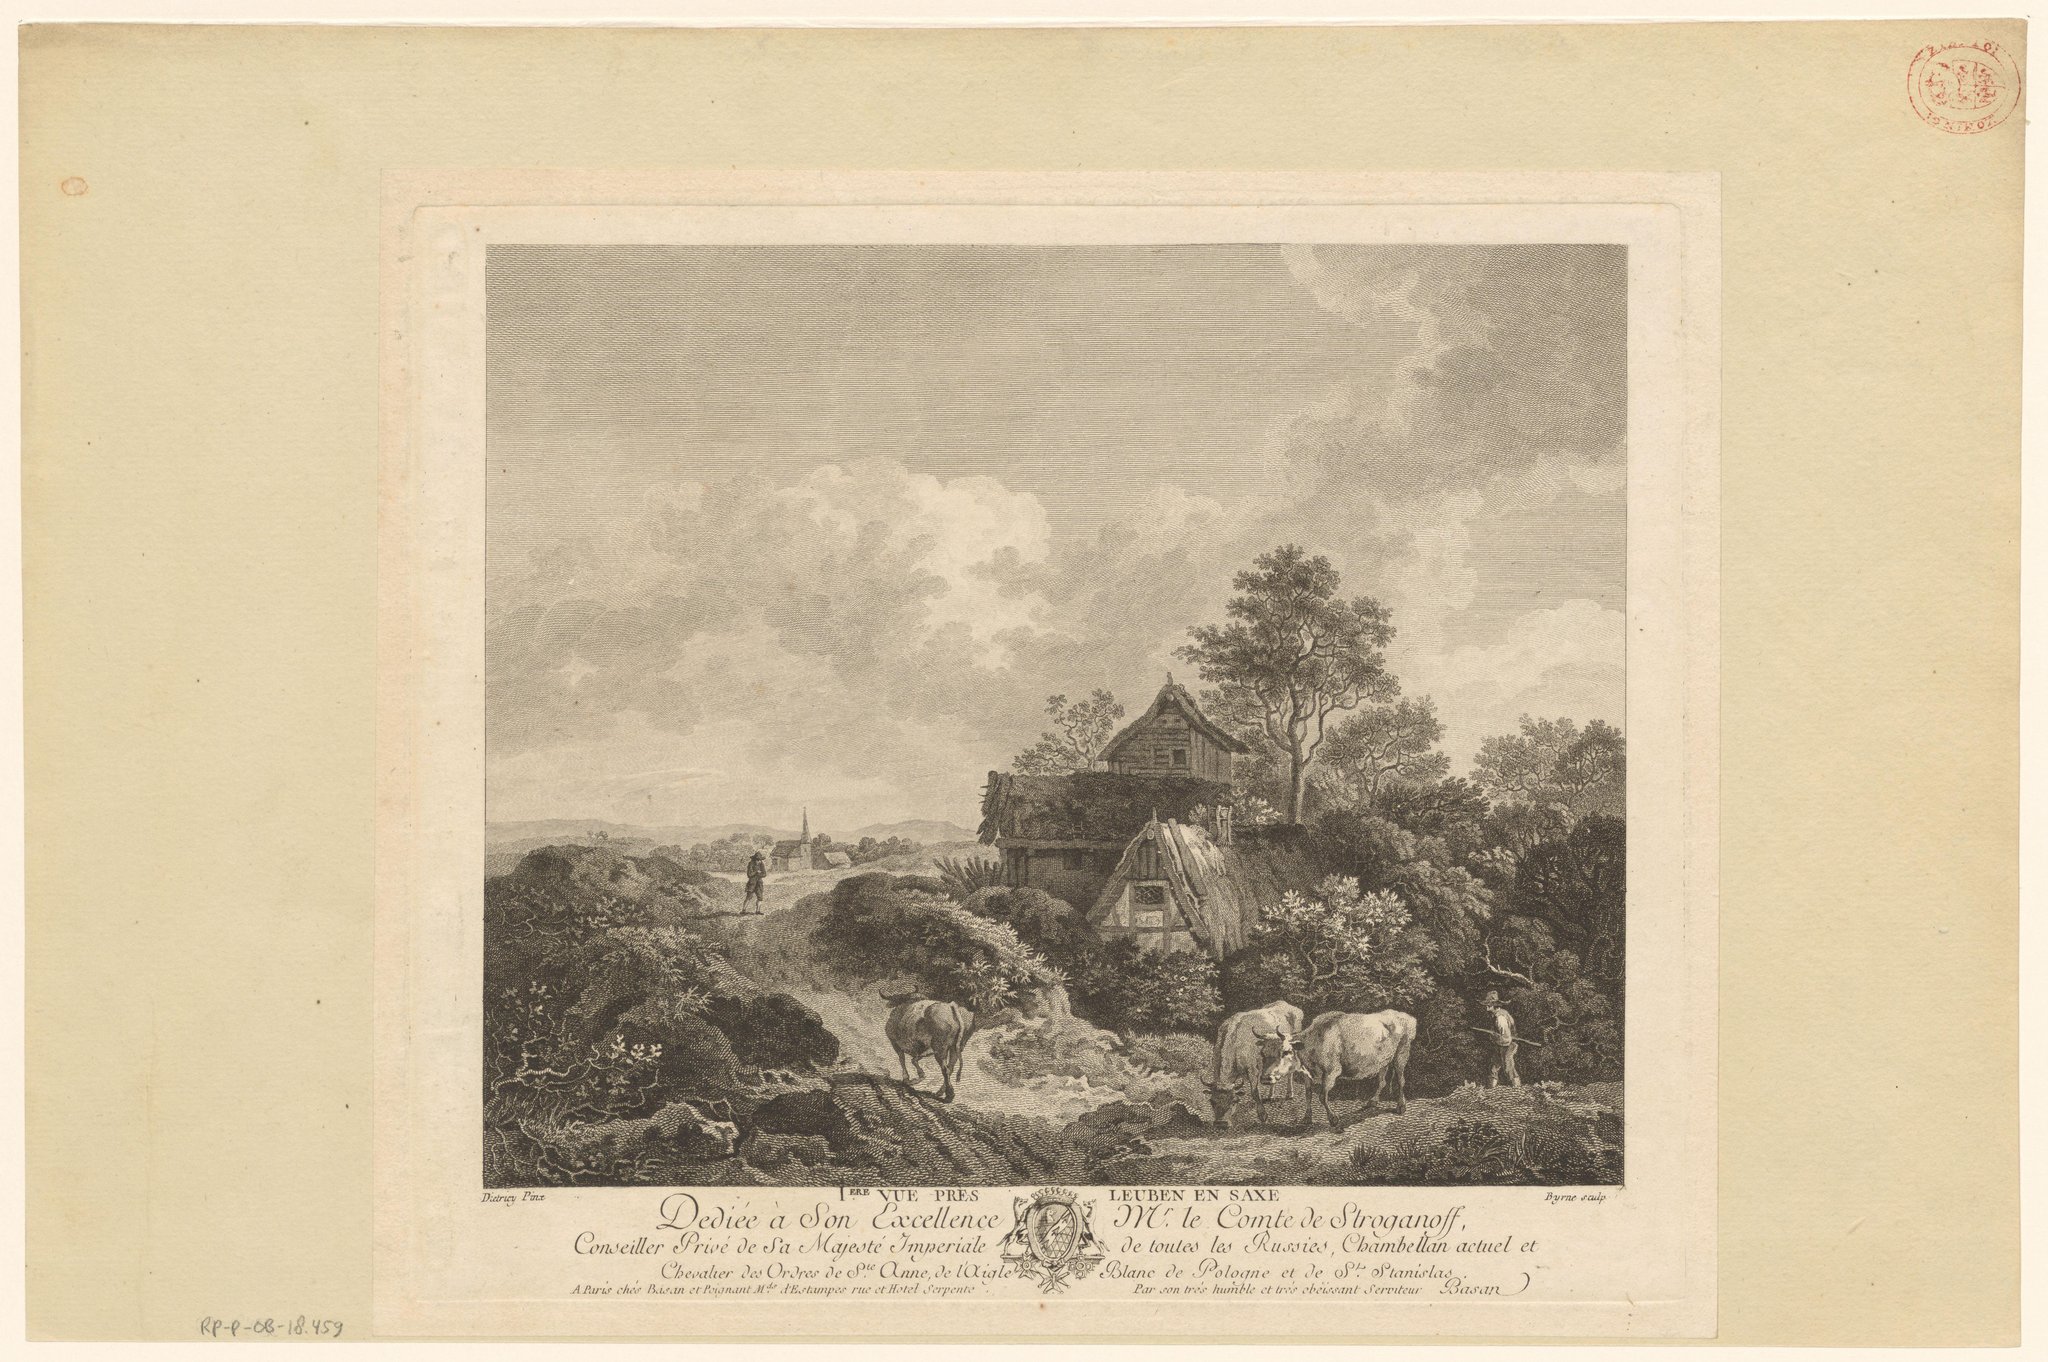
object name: print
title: Landschap met hutten en koeien bij Leuben-Schleinitz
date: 1773-1788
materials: paper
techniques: etching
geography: paris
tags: cow, herding, herdsman, herdswoman, shepherd, shepherdess, cowherd, etc., cottage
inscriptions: collector's mark: Lugt 240